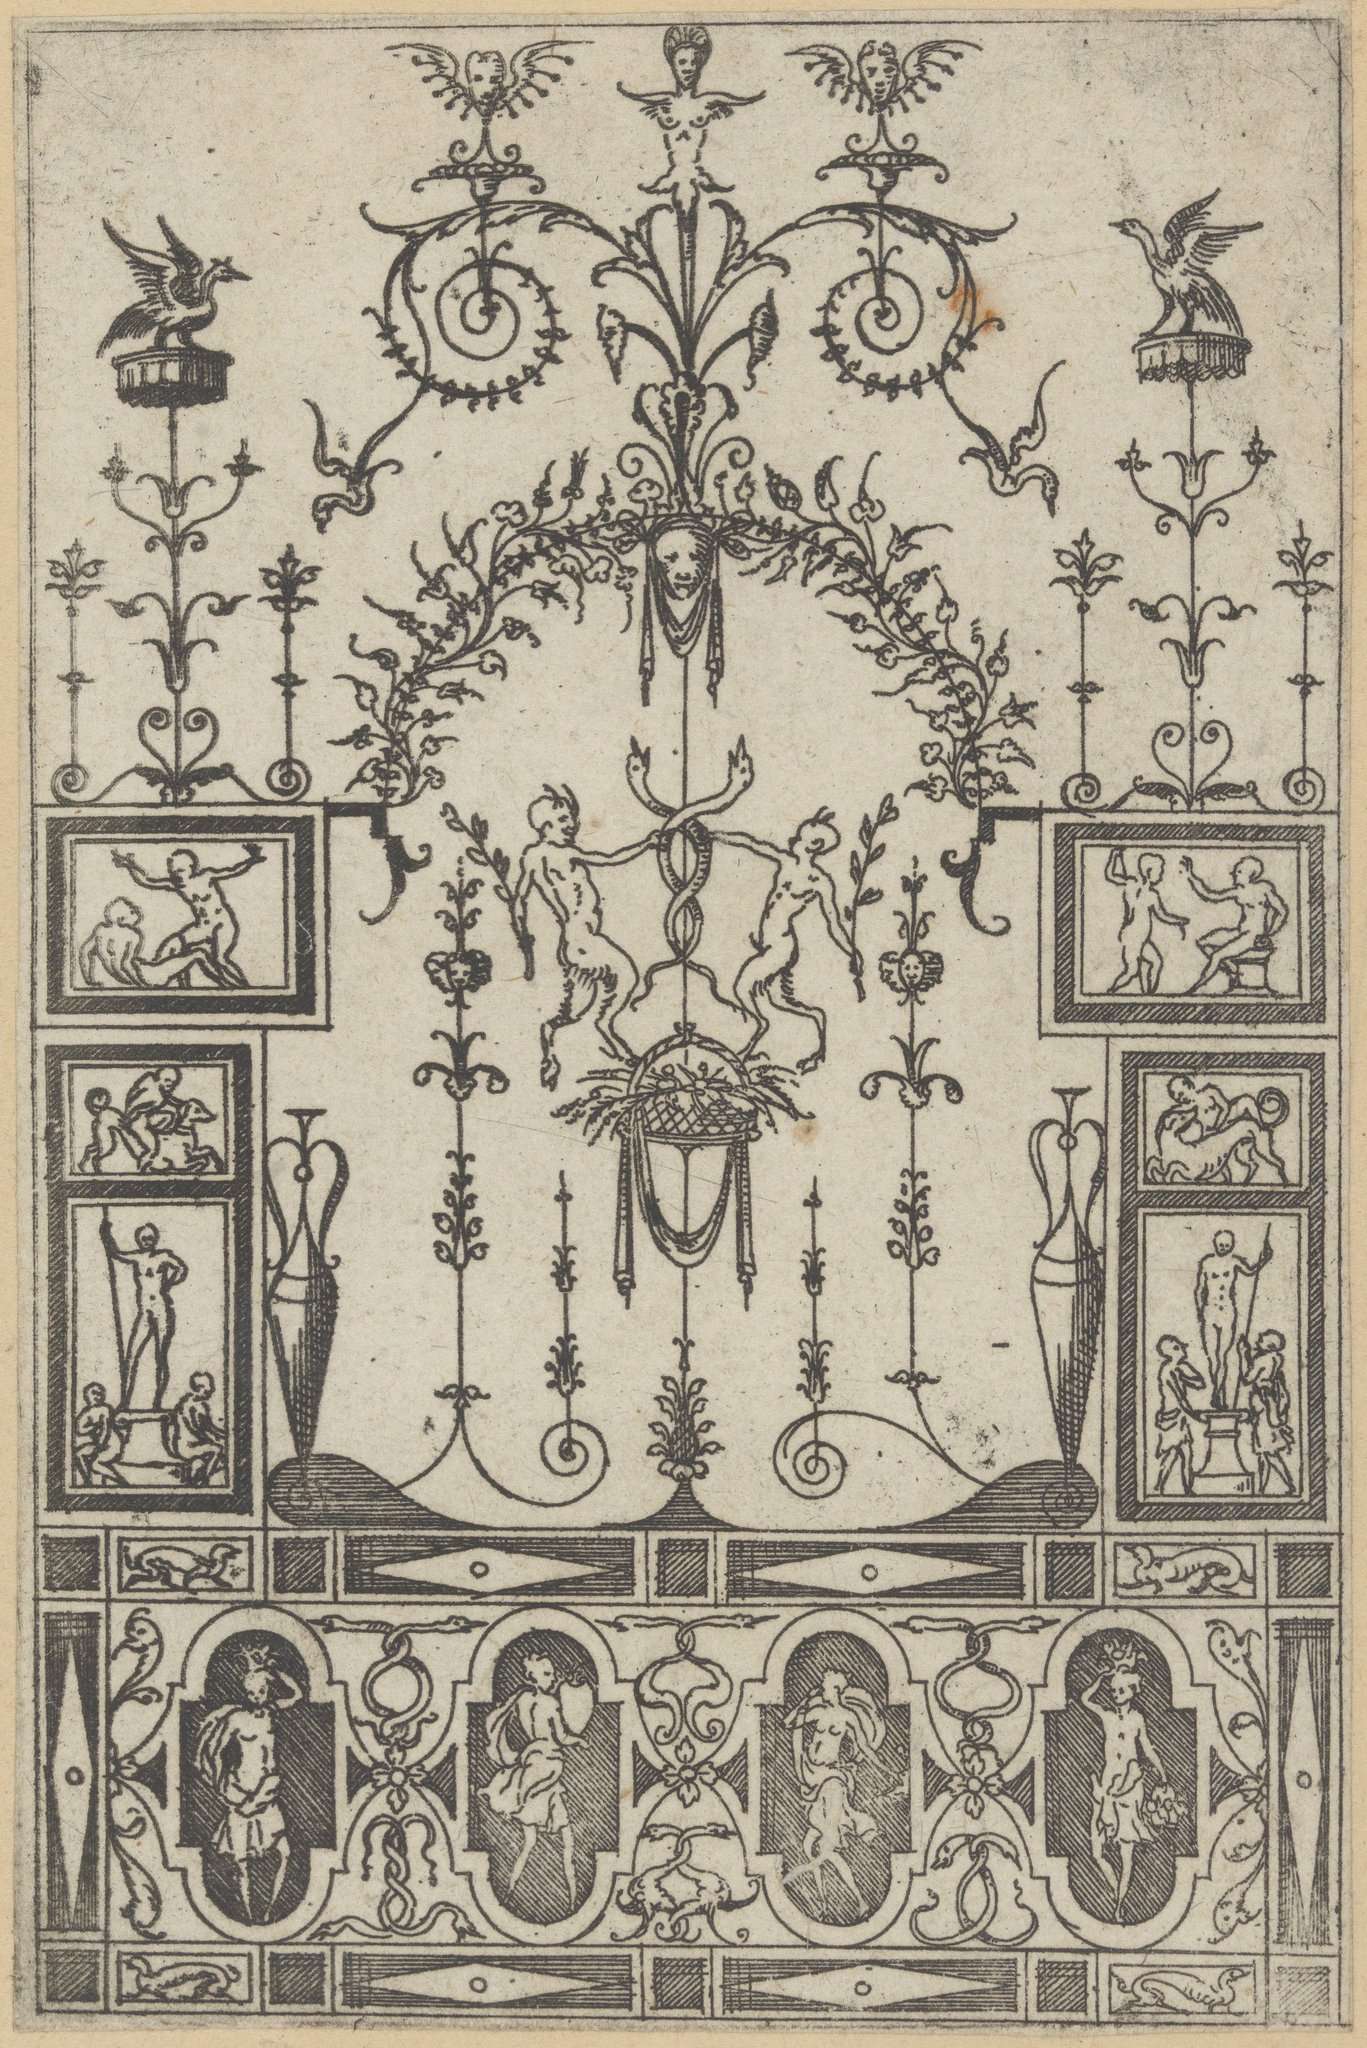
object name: print ornament architecture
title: Grotesque Panel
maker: jacques androuet du cerceau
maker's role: artist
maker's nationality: french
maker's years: 1510-1585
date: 1550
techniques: etching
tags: birds,grotesques,ornament,dancing